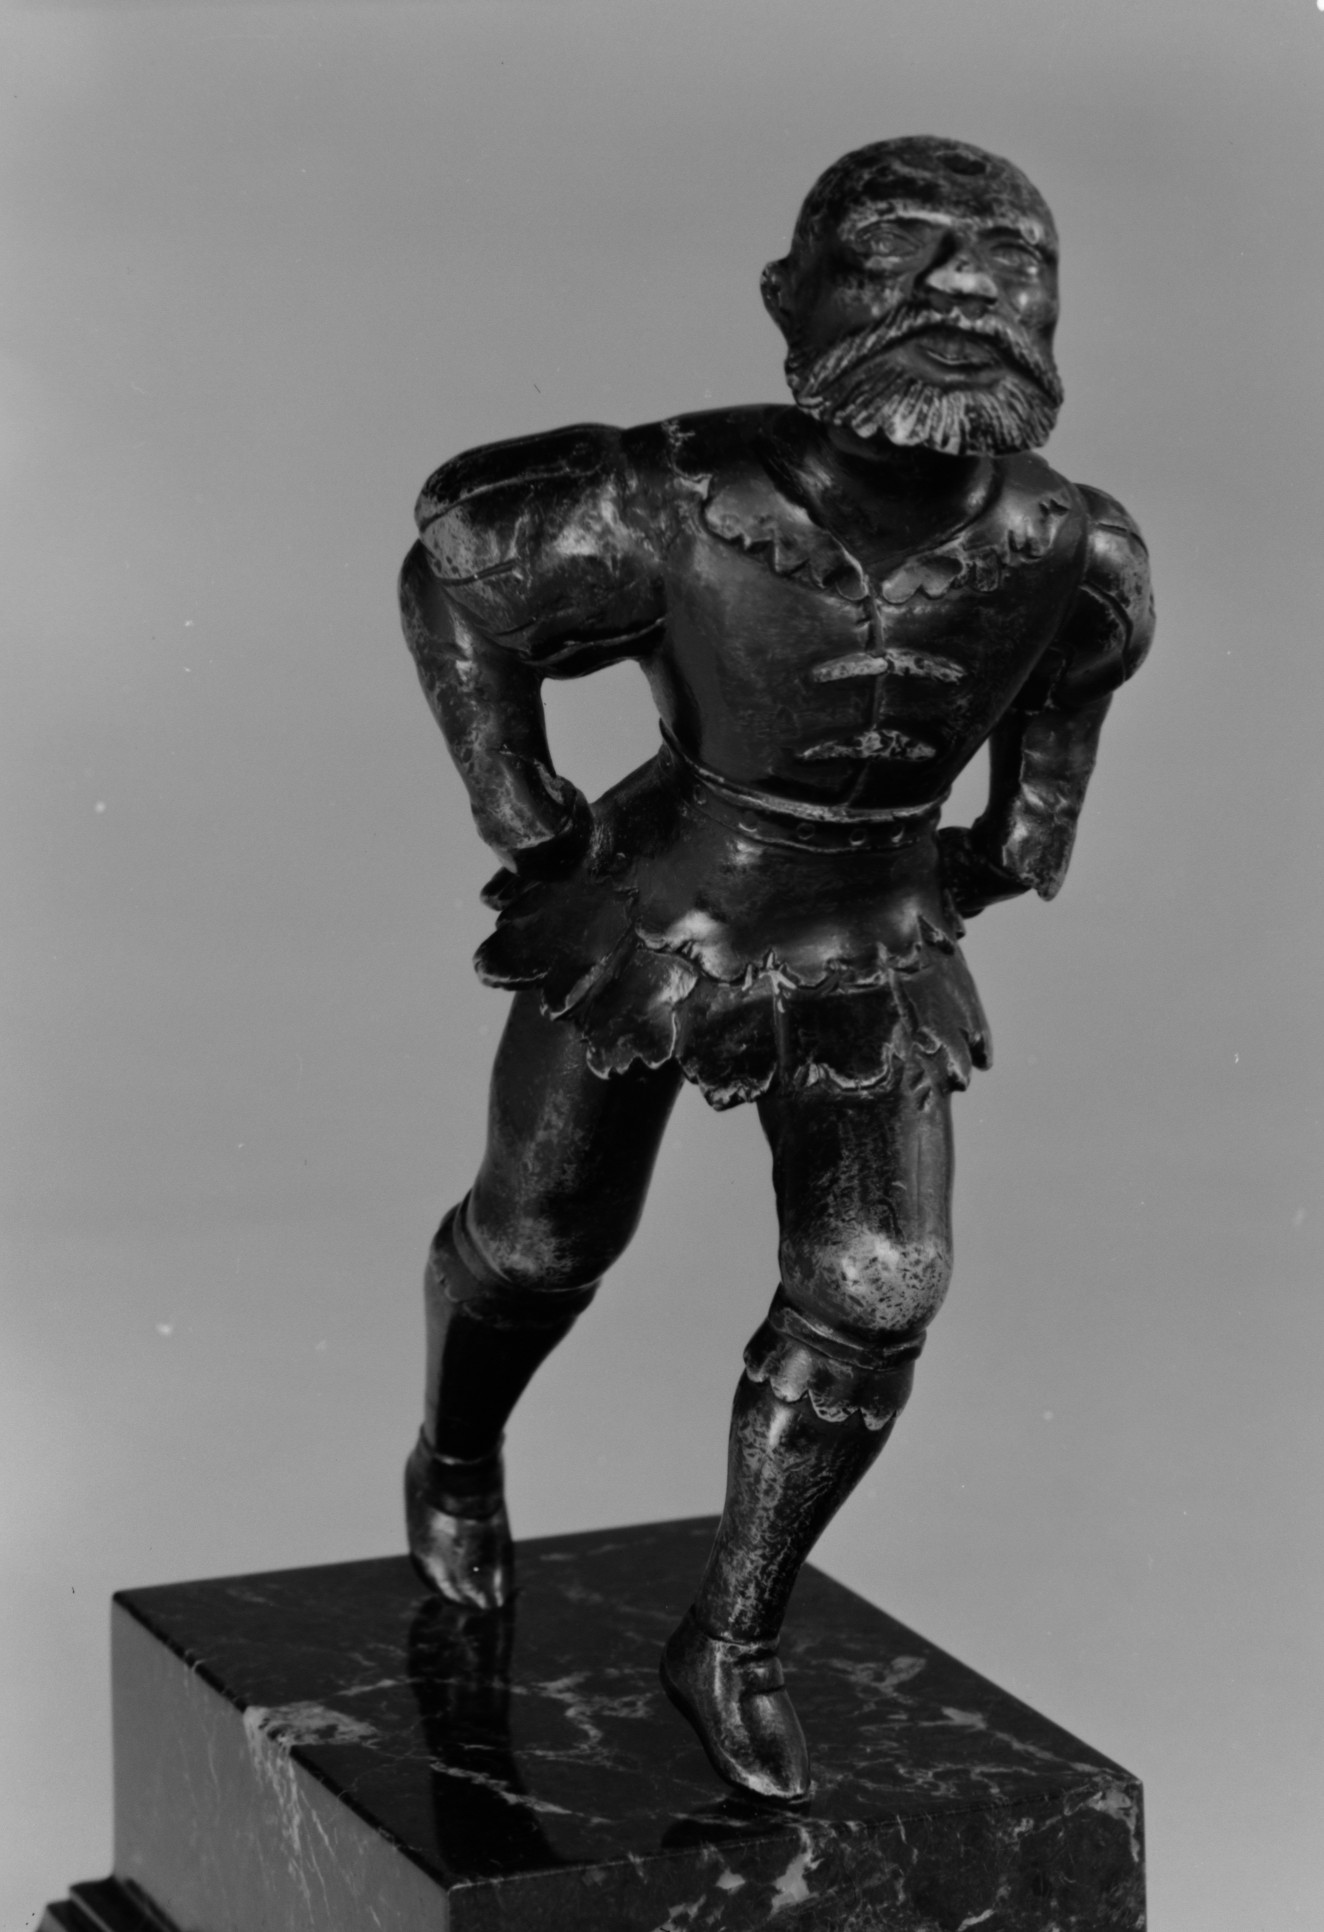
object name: statuette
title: Dancing Man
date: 1534-1566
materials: bronze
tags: men,dancing